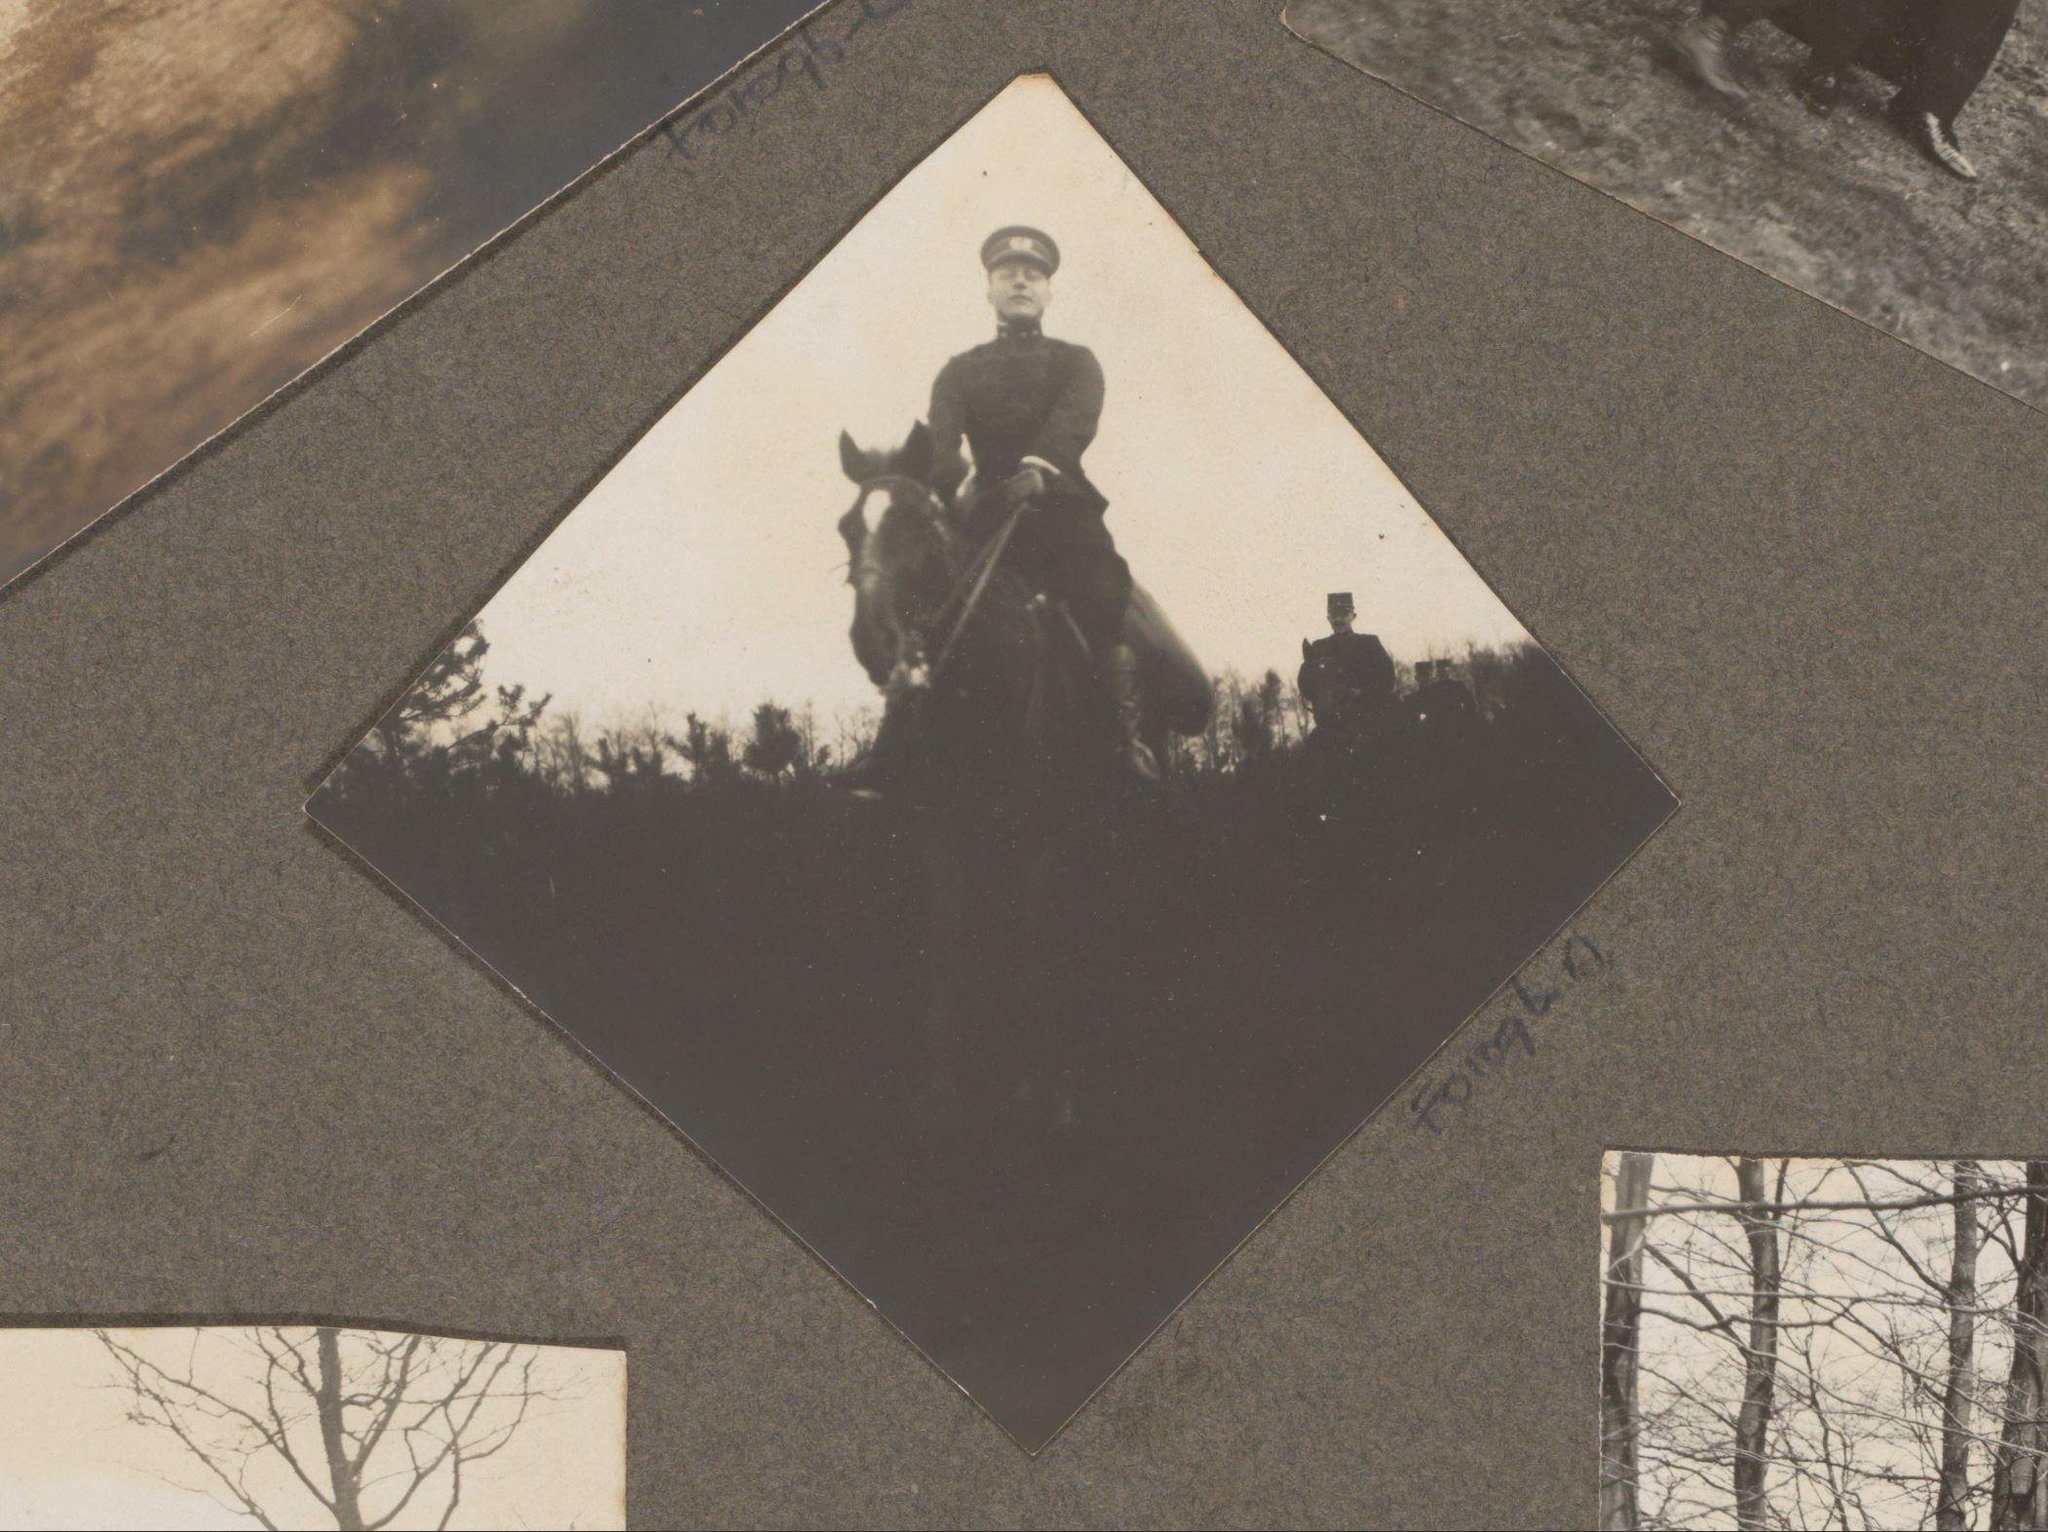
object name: album leaf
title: Ruitertafereel op Koninklijke Houtvesterij Het Loo: twee ruiters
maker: Anonymous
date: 1900-1925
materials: photographic support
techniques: gelatin silver print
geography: het loo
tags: riding a horse, ass, or mule; rider, horseman, hunting, chase, hunting-ground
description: Onderdeel van Fotoalbum van de heer Brams, opperhoutvester van koningin Wilhelmina op Koninklijke Houtvesterij Het Loo.